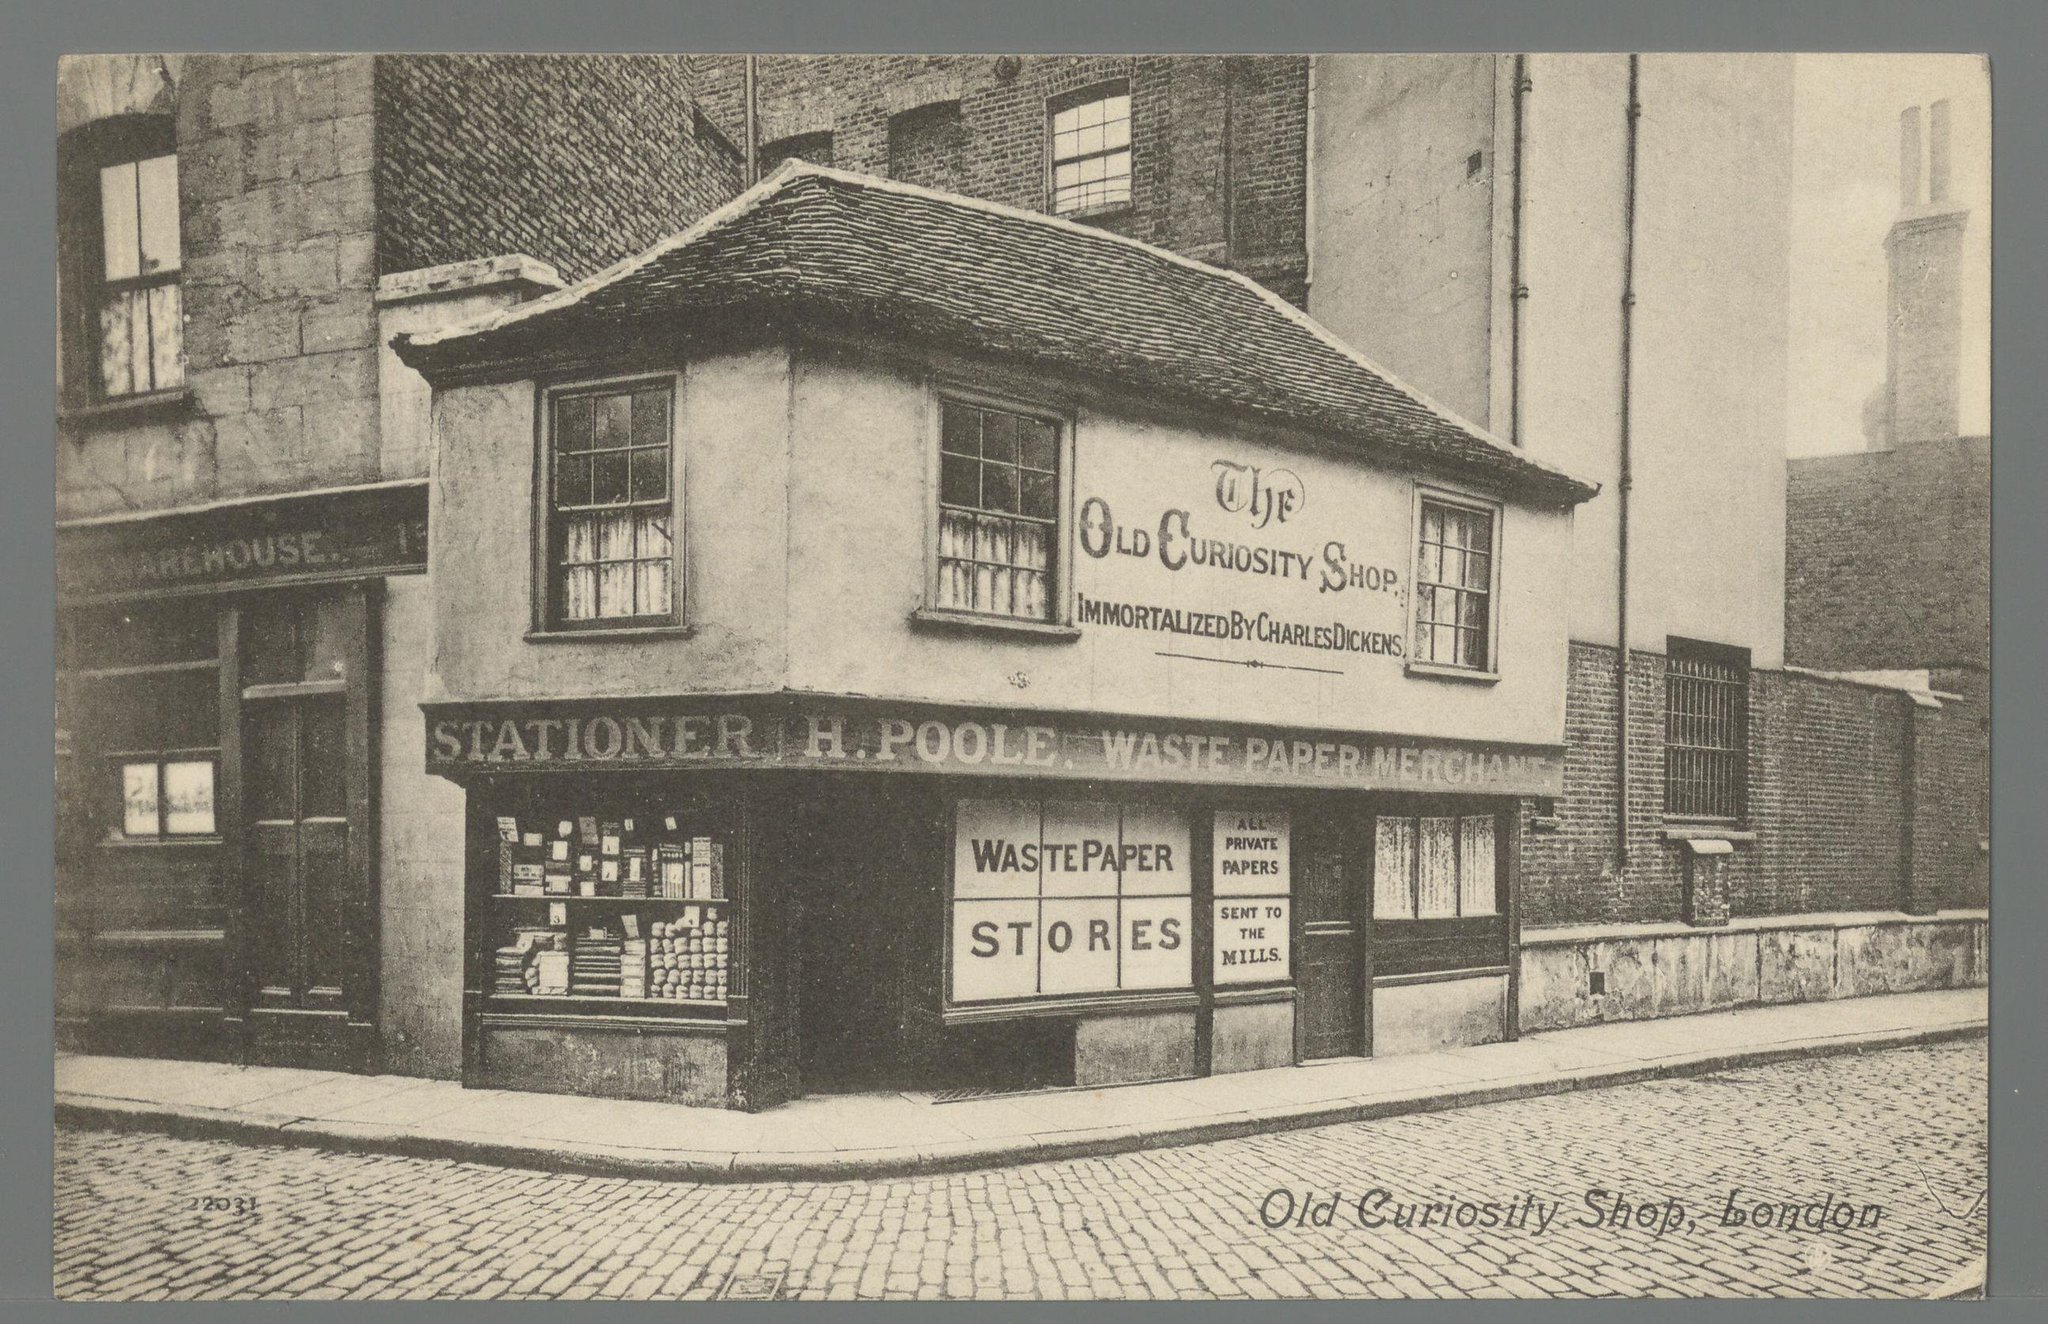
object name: photomechanical print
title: Valentine's Series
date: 1902-1930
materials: cardboard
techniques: photograph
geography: dundee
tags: shop, store, london